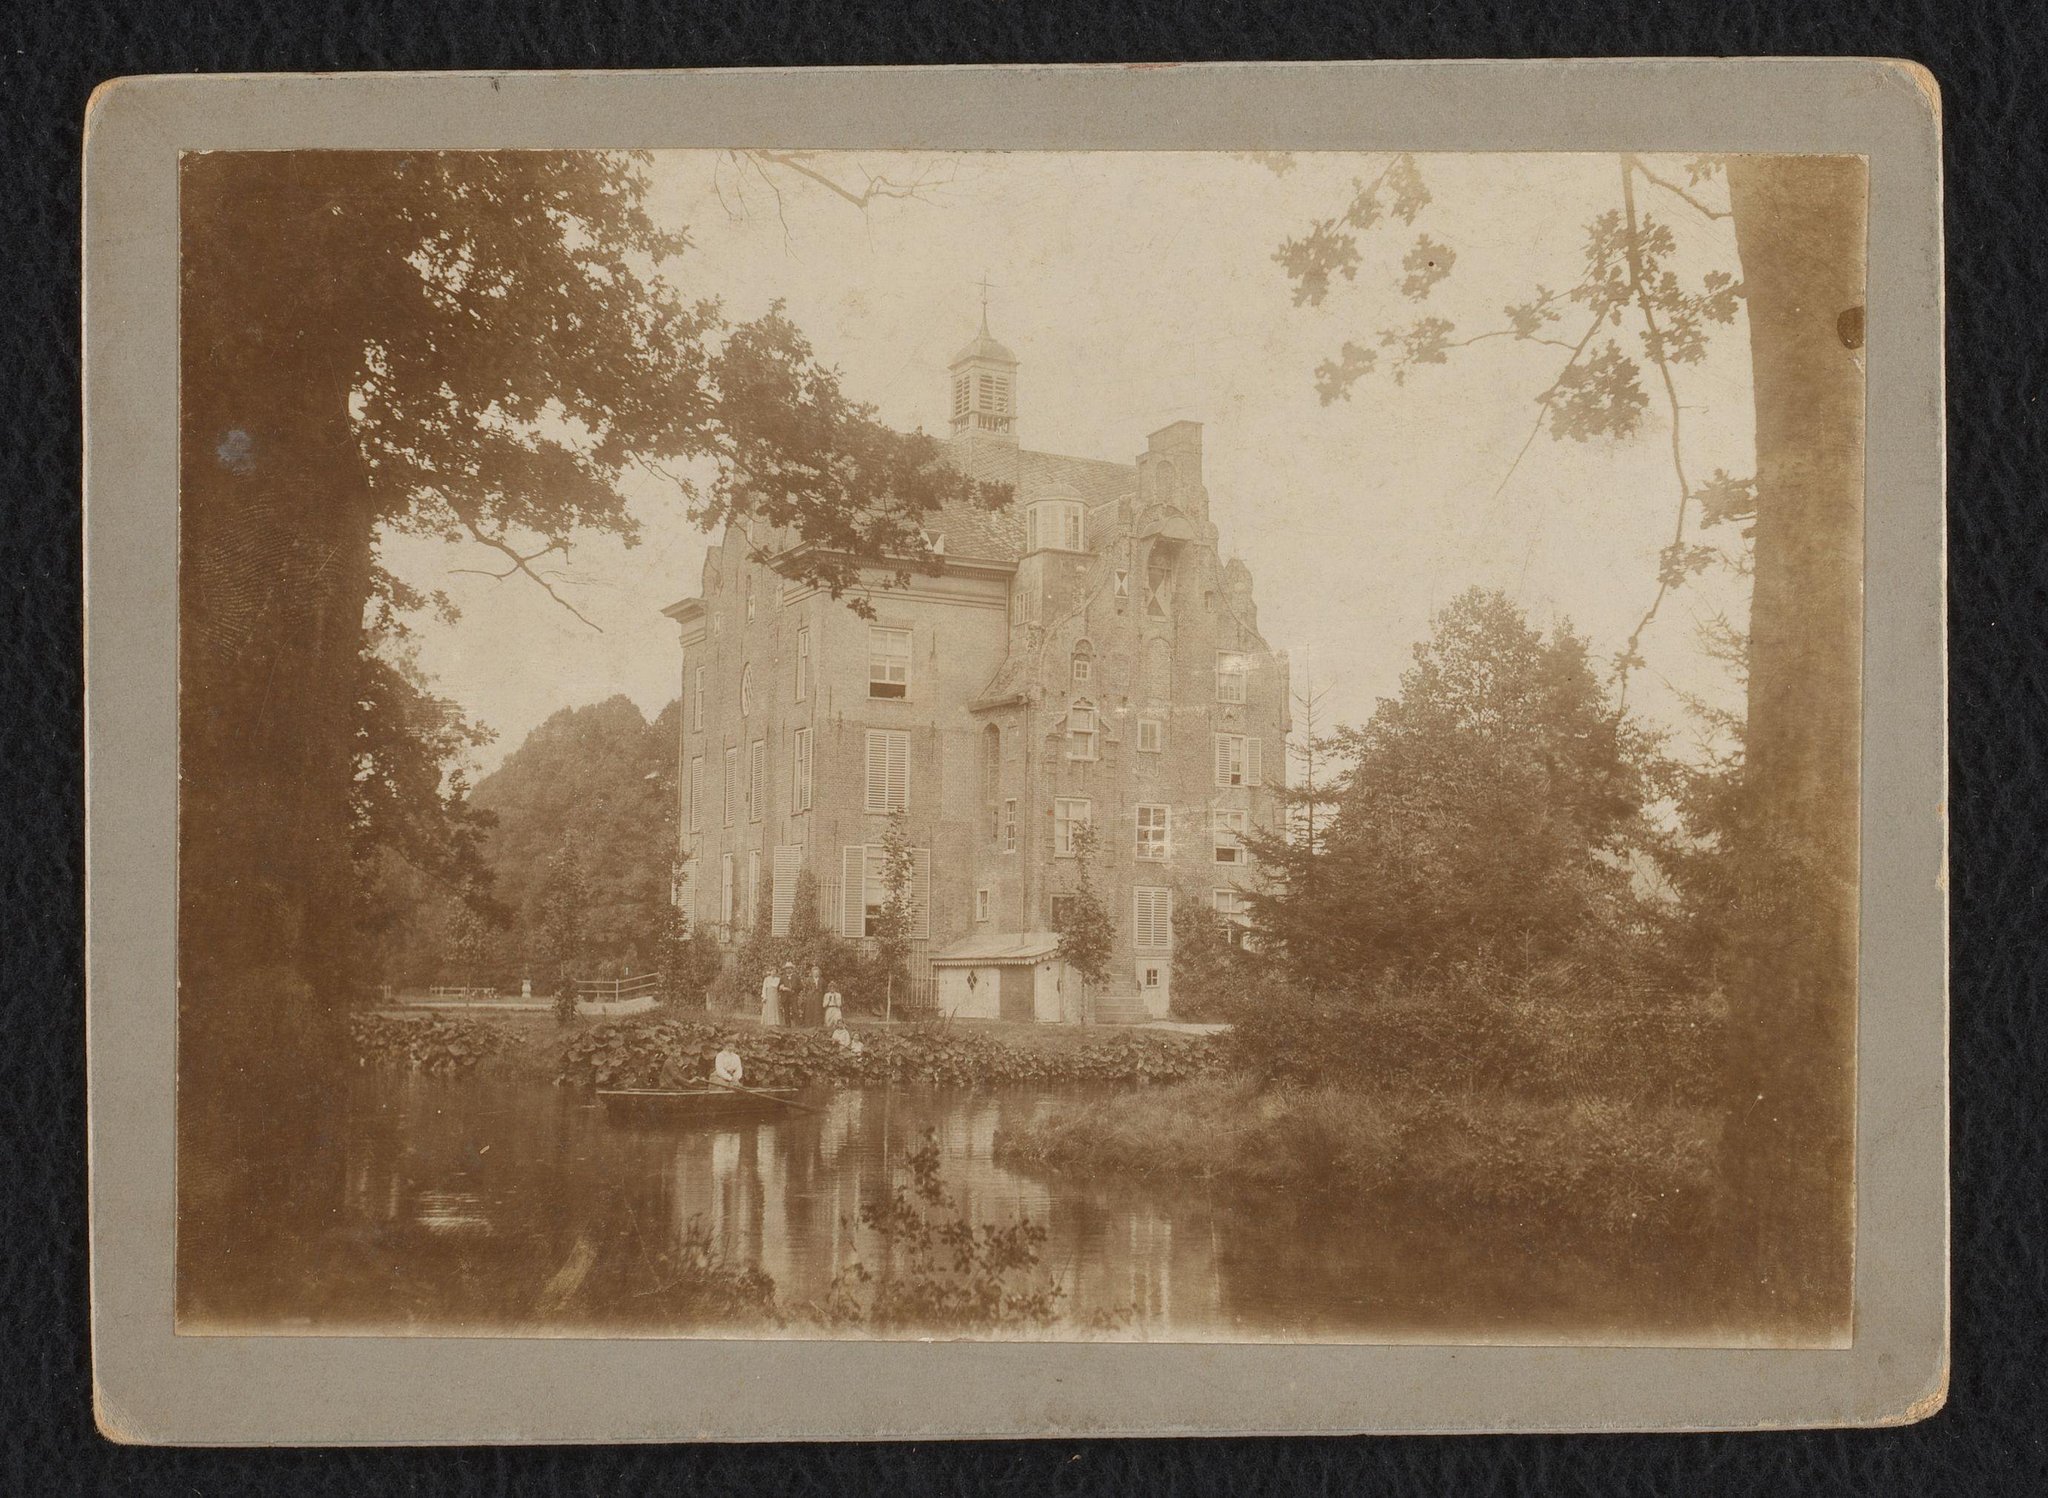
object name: cabinet photograph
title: Gezin Kessler bij een burcht, onder andere Margo Kessler-de Lange, haar kinderen Dolph, An, Go en schoonzoon Philip Kohnstamm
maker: Anonymous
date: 1903-1910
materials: paper, cardboard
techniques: collodion silver print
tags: physicist, batavia, geldolph adriaan kessler (dolph), margaretha jacoba johanna kessler-de lange (margo), fortress